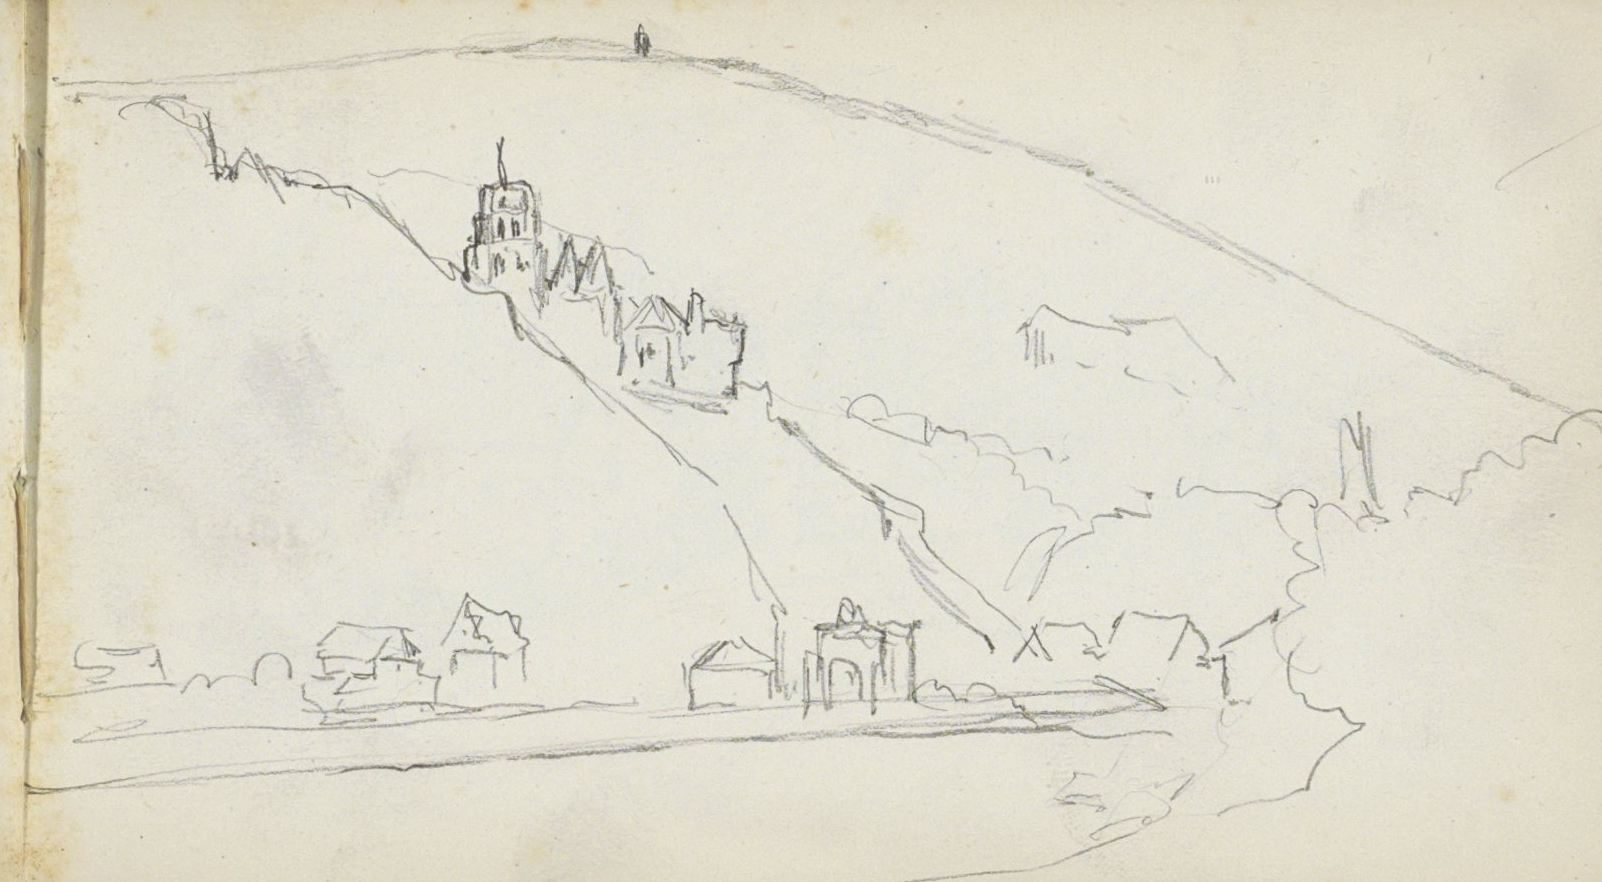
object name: sketchbook leaf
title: Heidelberg aan de Neckar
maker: geo poggenbeek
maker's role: draughtsman, painter, print maker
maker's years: 1853-1903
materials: paper, pencil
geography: heidelberg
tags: castle, river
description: Gezicht op Schloss Heidelberg. Blad 32 recto uit een schetsboek met 69 bladen.